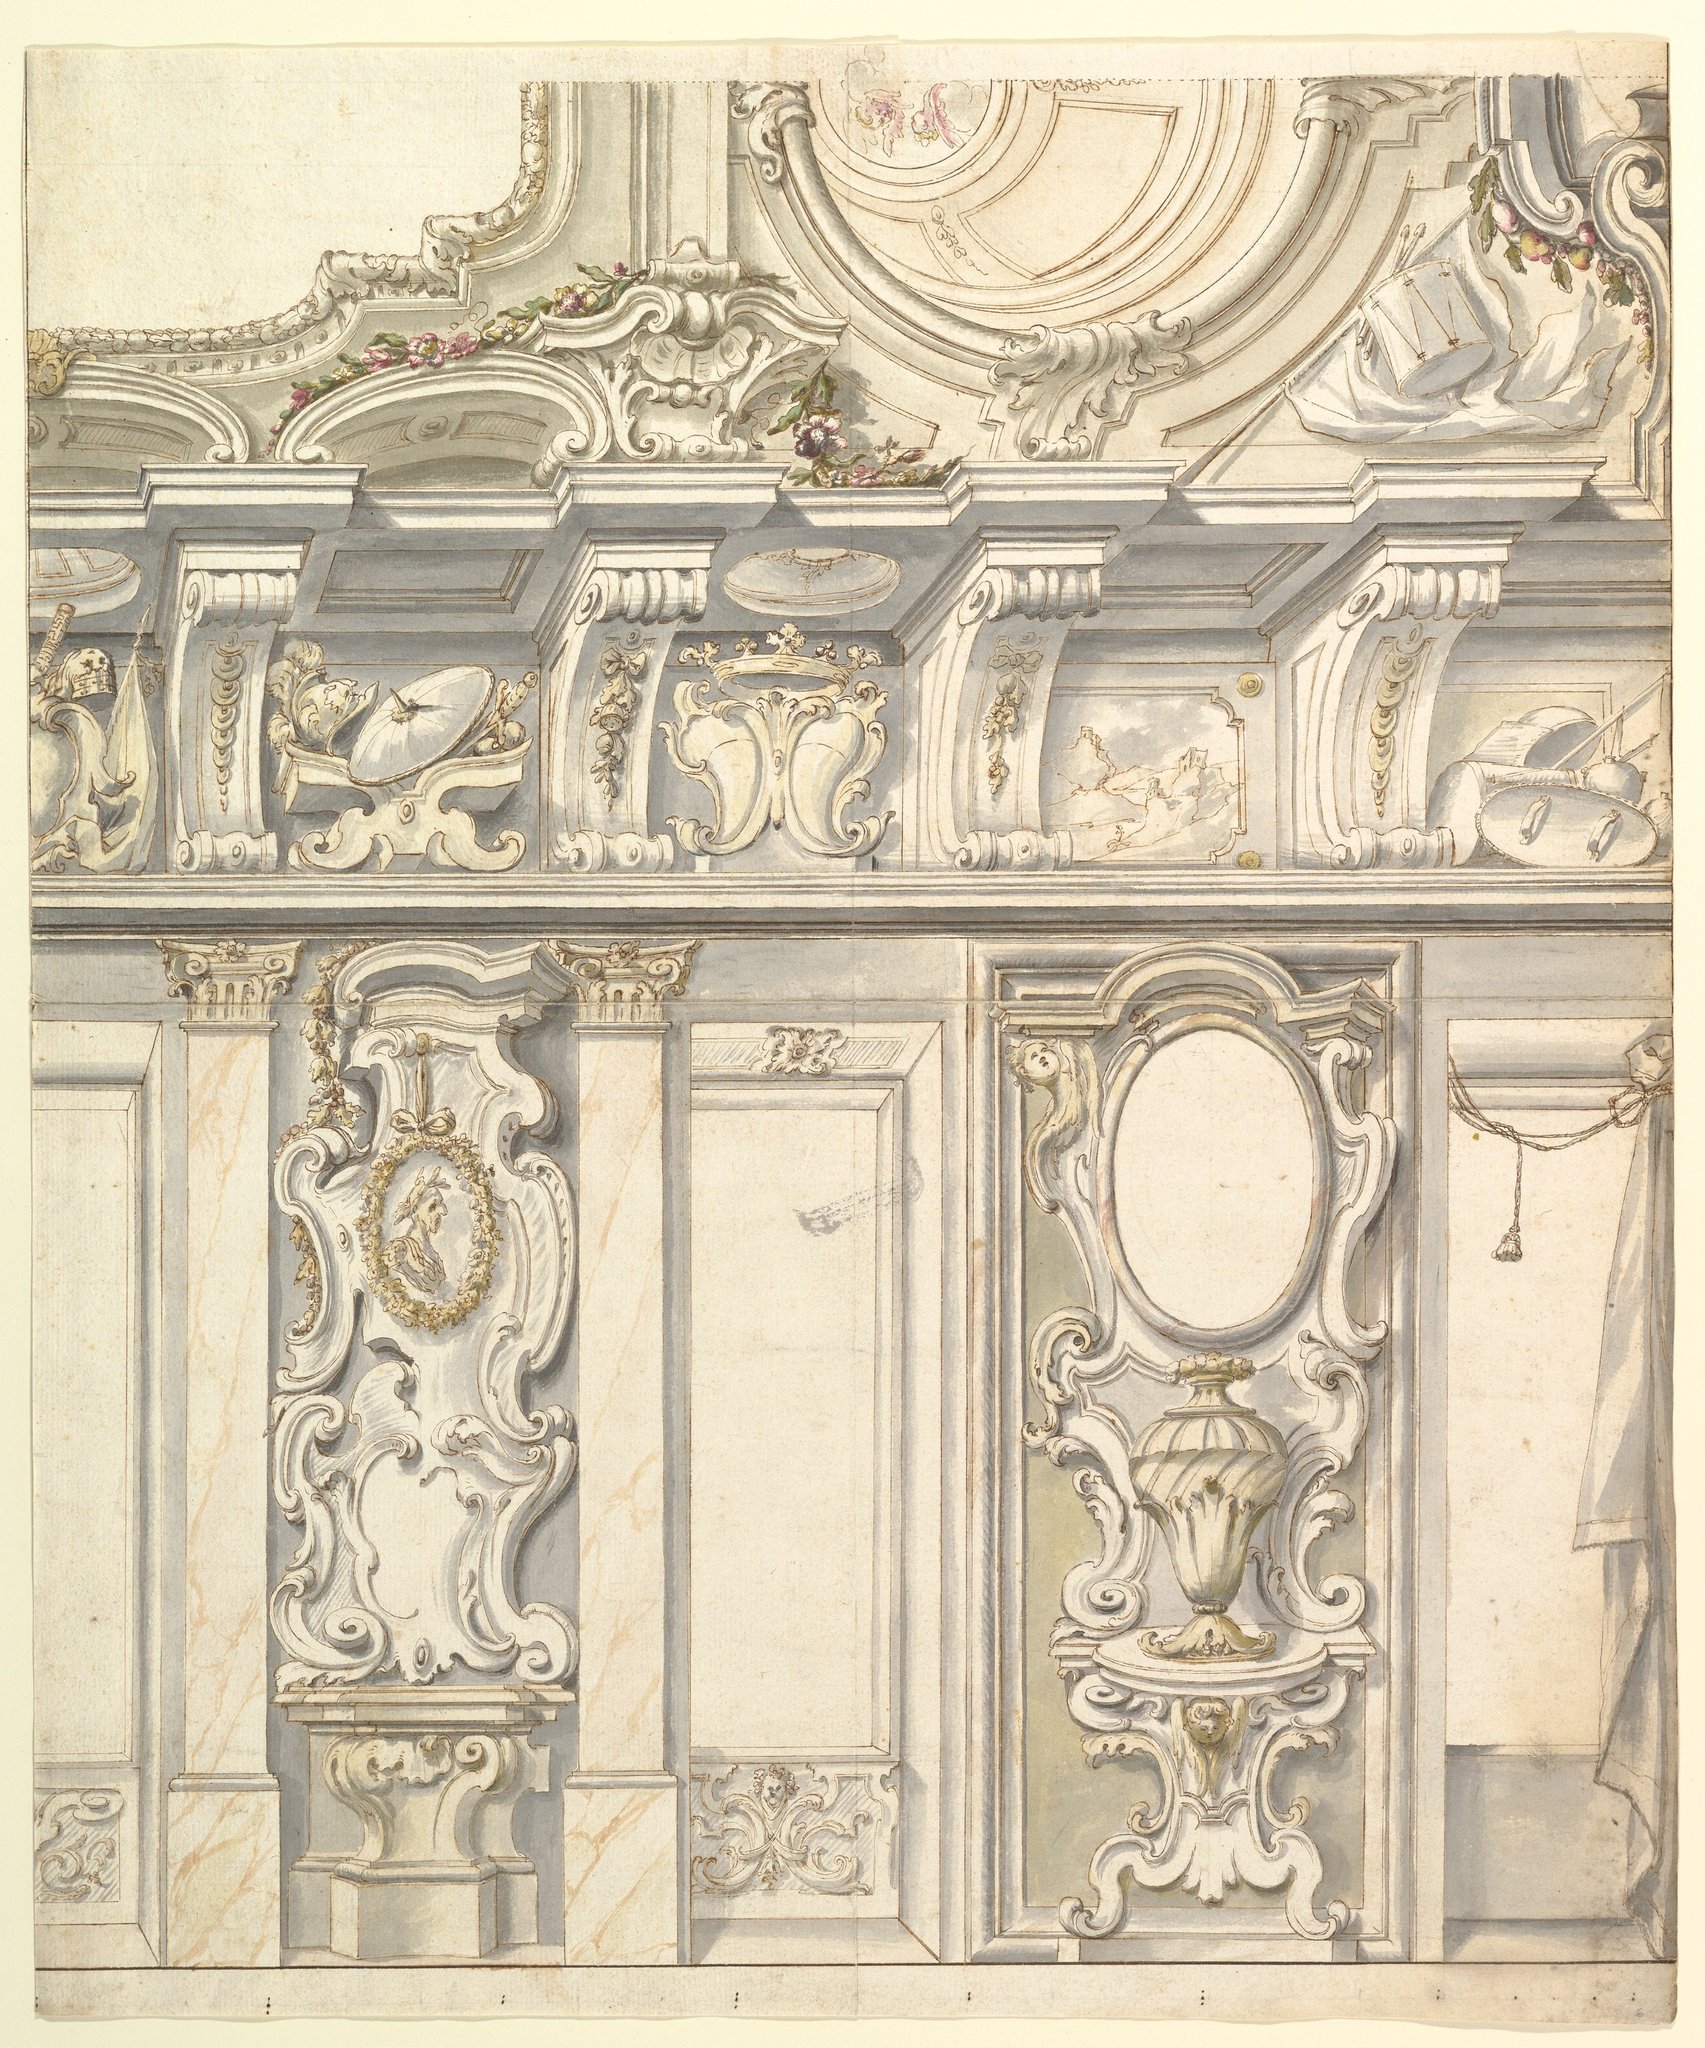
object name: drawing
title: Design for Elevation for Elaborate Wall and Vault with the Savoya Arms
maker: anonymous, italian, piedmontese, 18th century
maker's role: artist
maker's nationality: italian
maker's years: 1700-1800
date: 1700-1780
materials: graphite, ink, drawing material, watercolor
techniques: brush, pen, wash